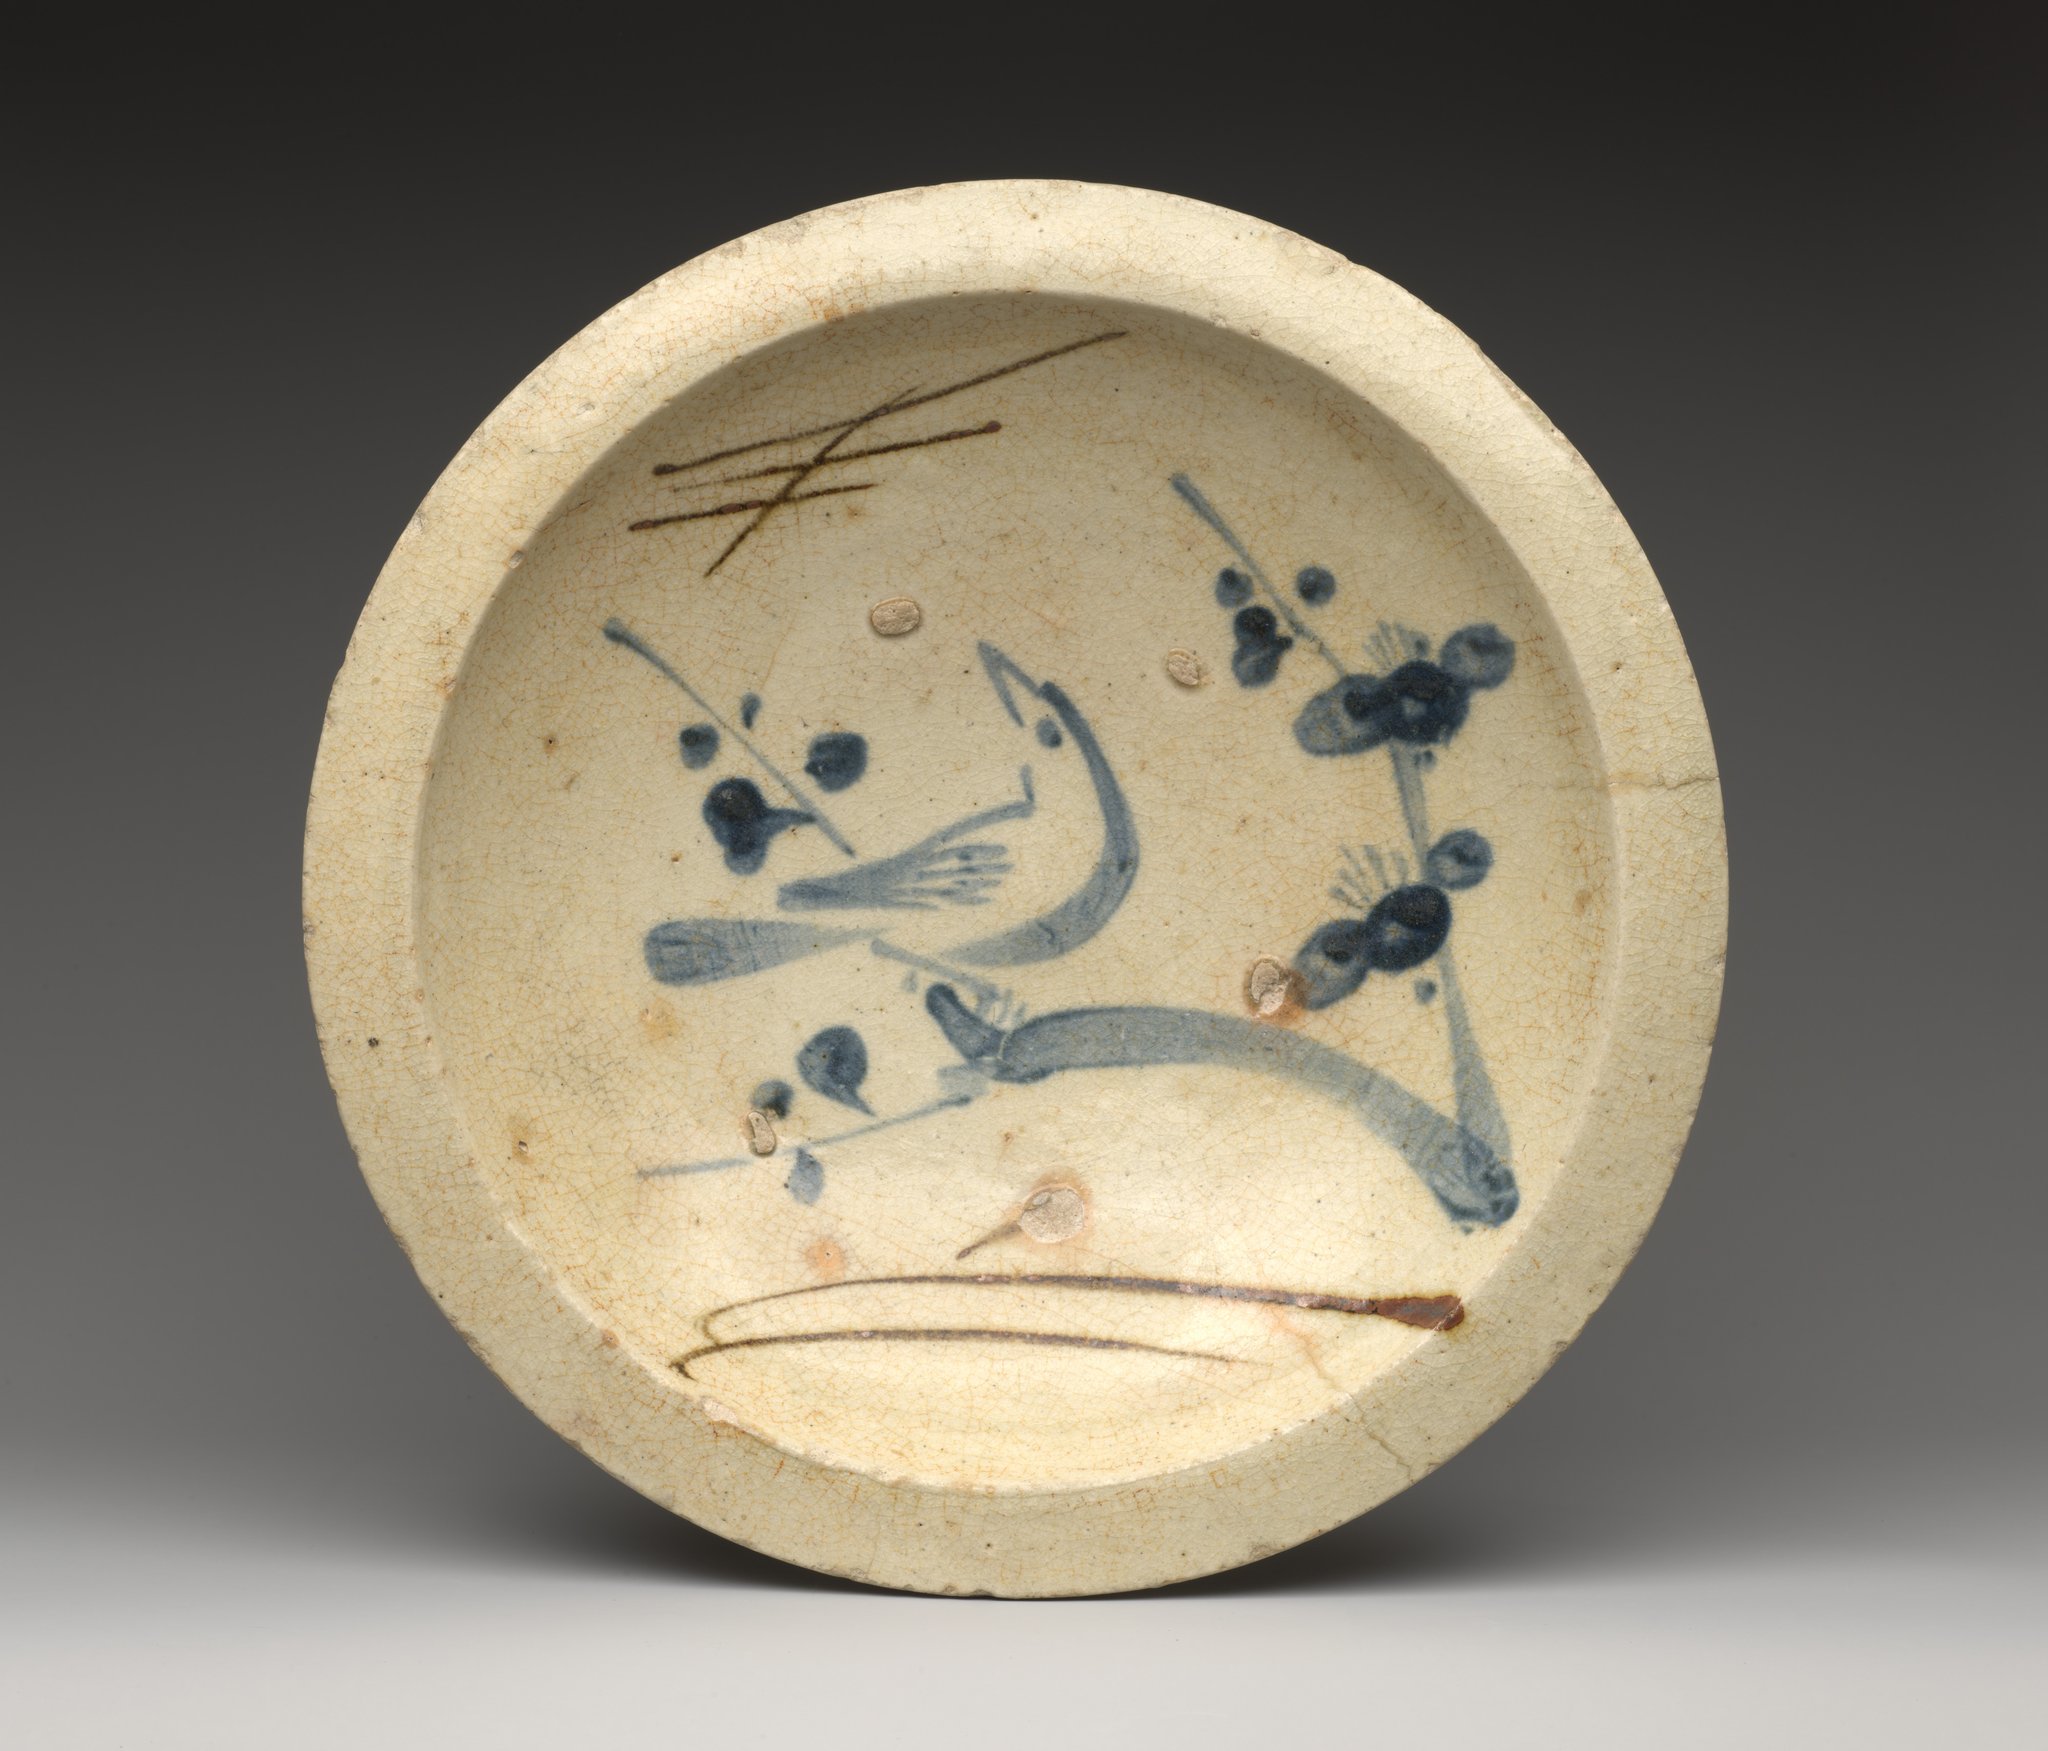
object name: plate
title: Ishizara Plate with Design of Bird on a Branch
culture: japanese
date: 1767-1833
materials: stoneware